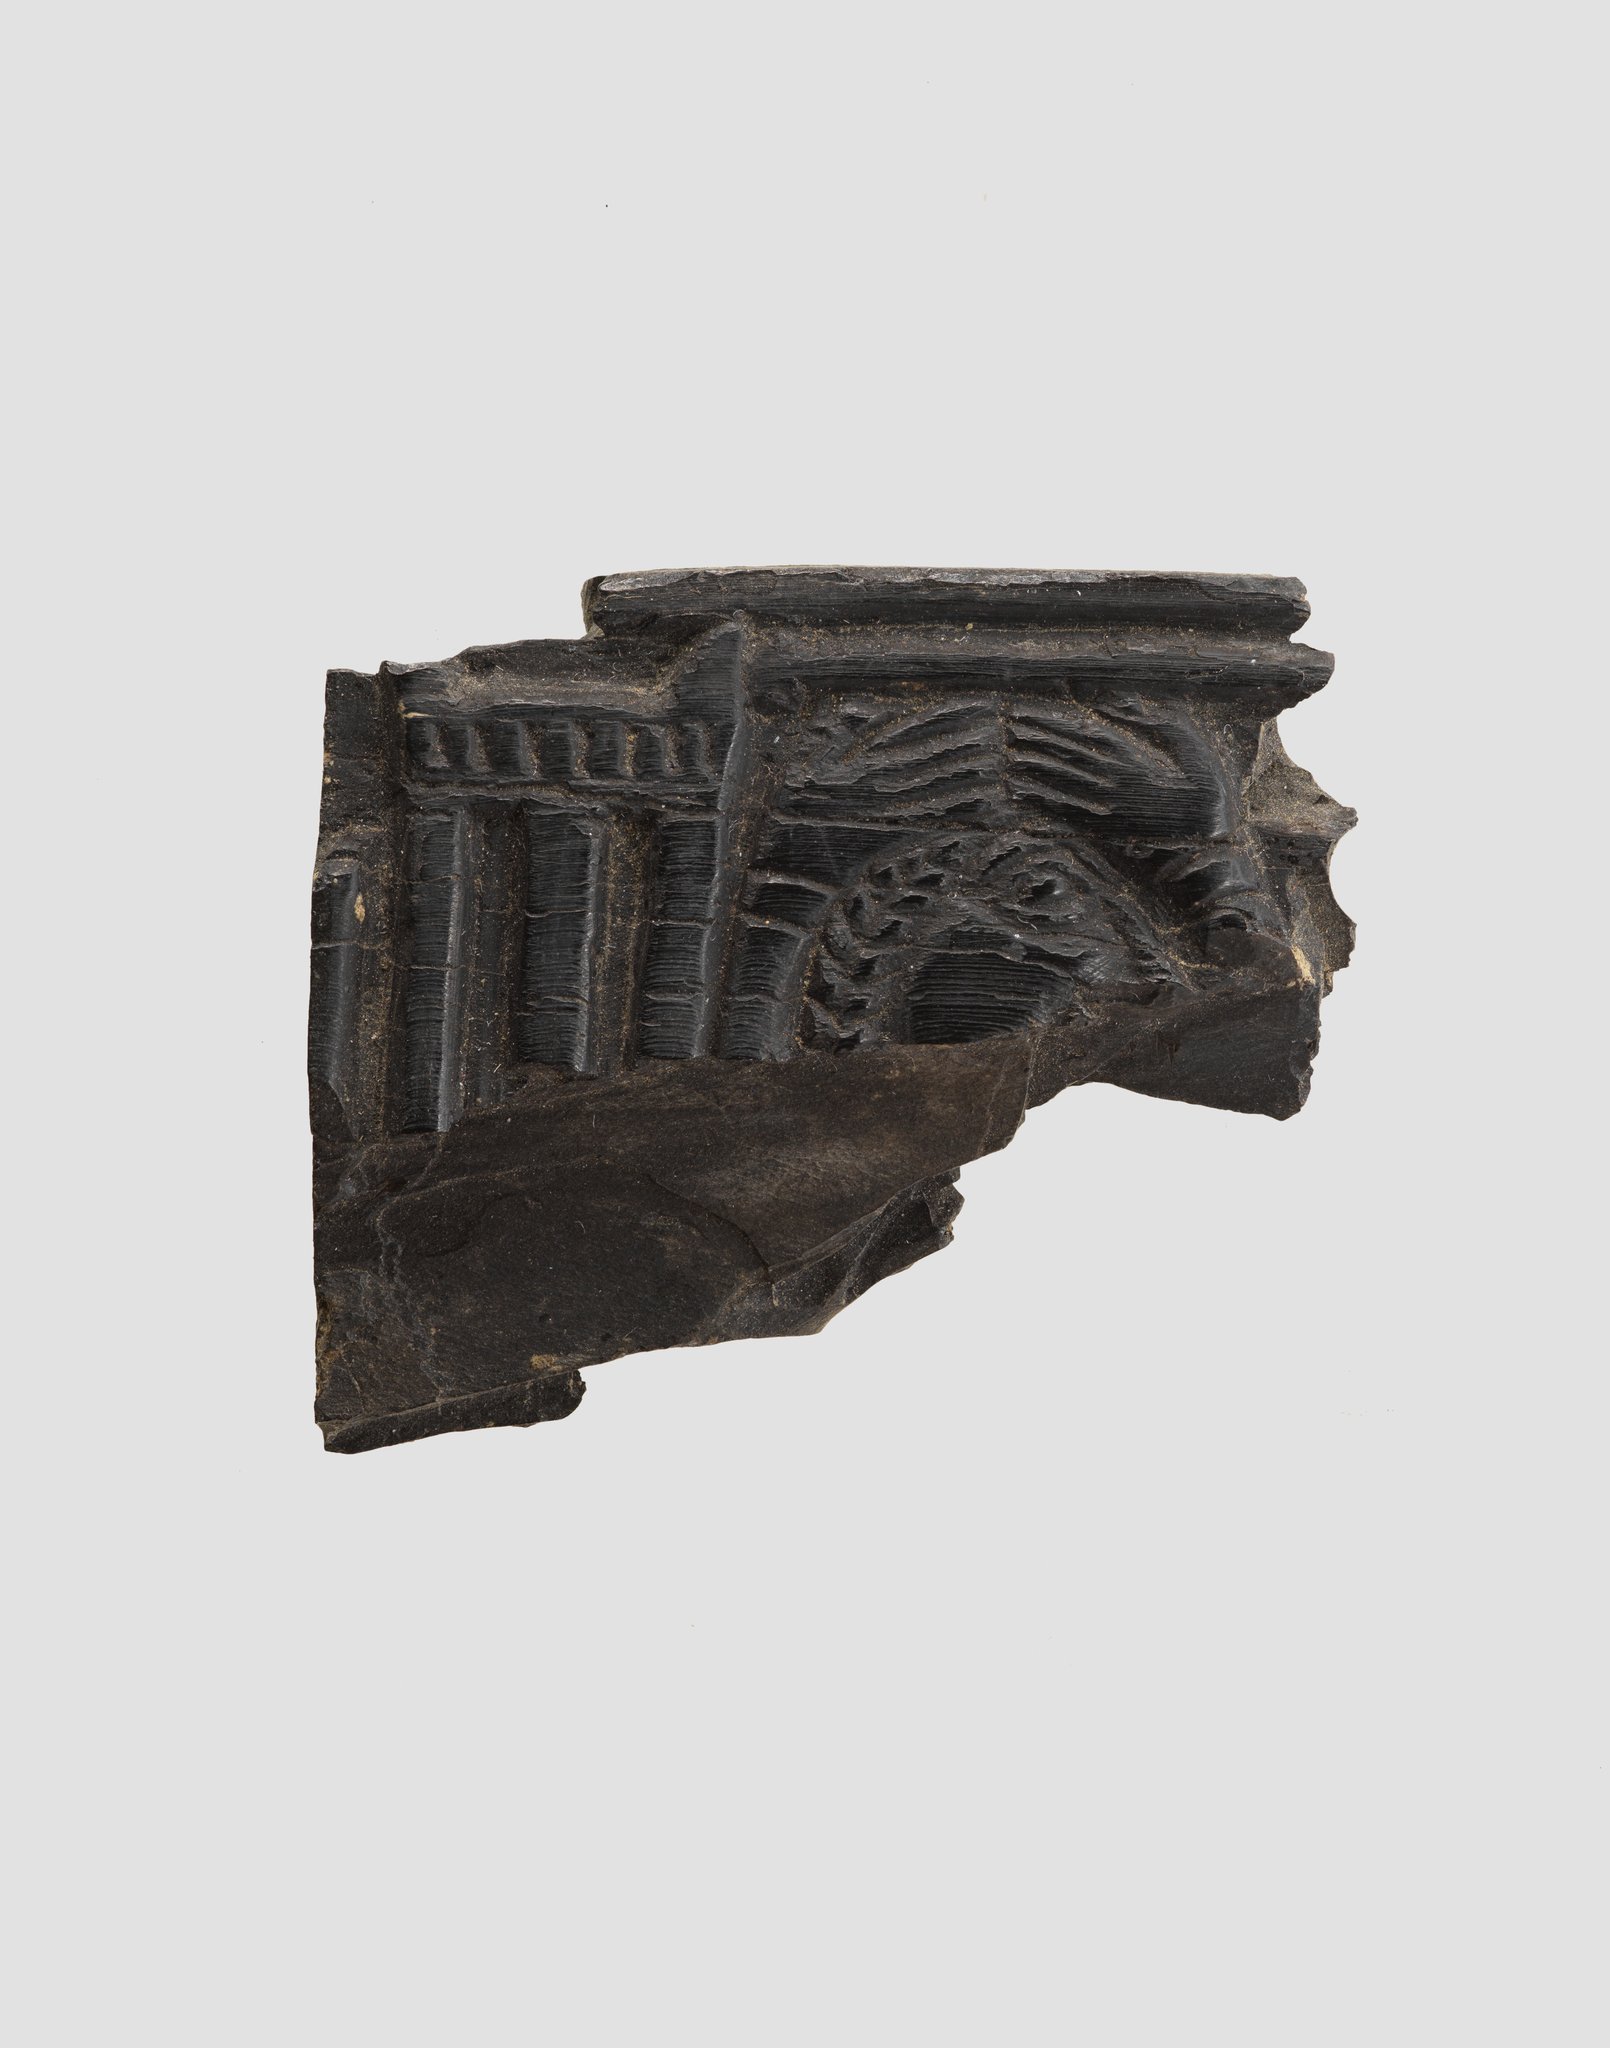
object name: relief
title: Plaque fragment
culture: iranian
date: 900-801 BCE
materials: ivory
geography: iran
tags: eyes,hands